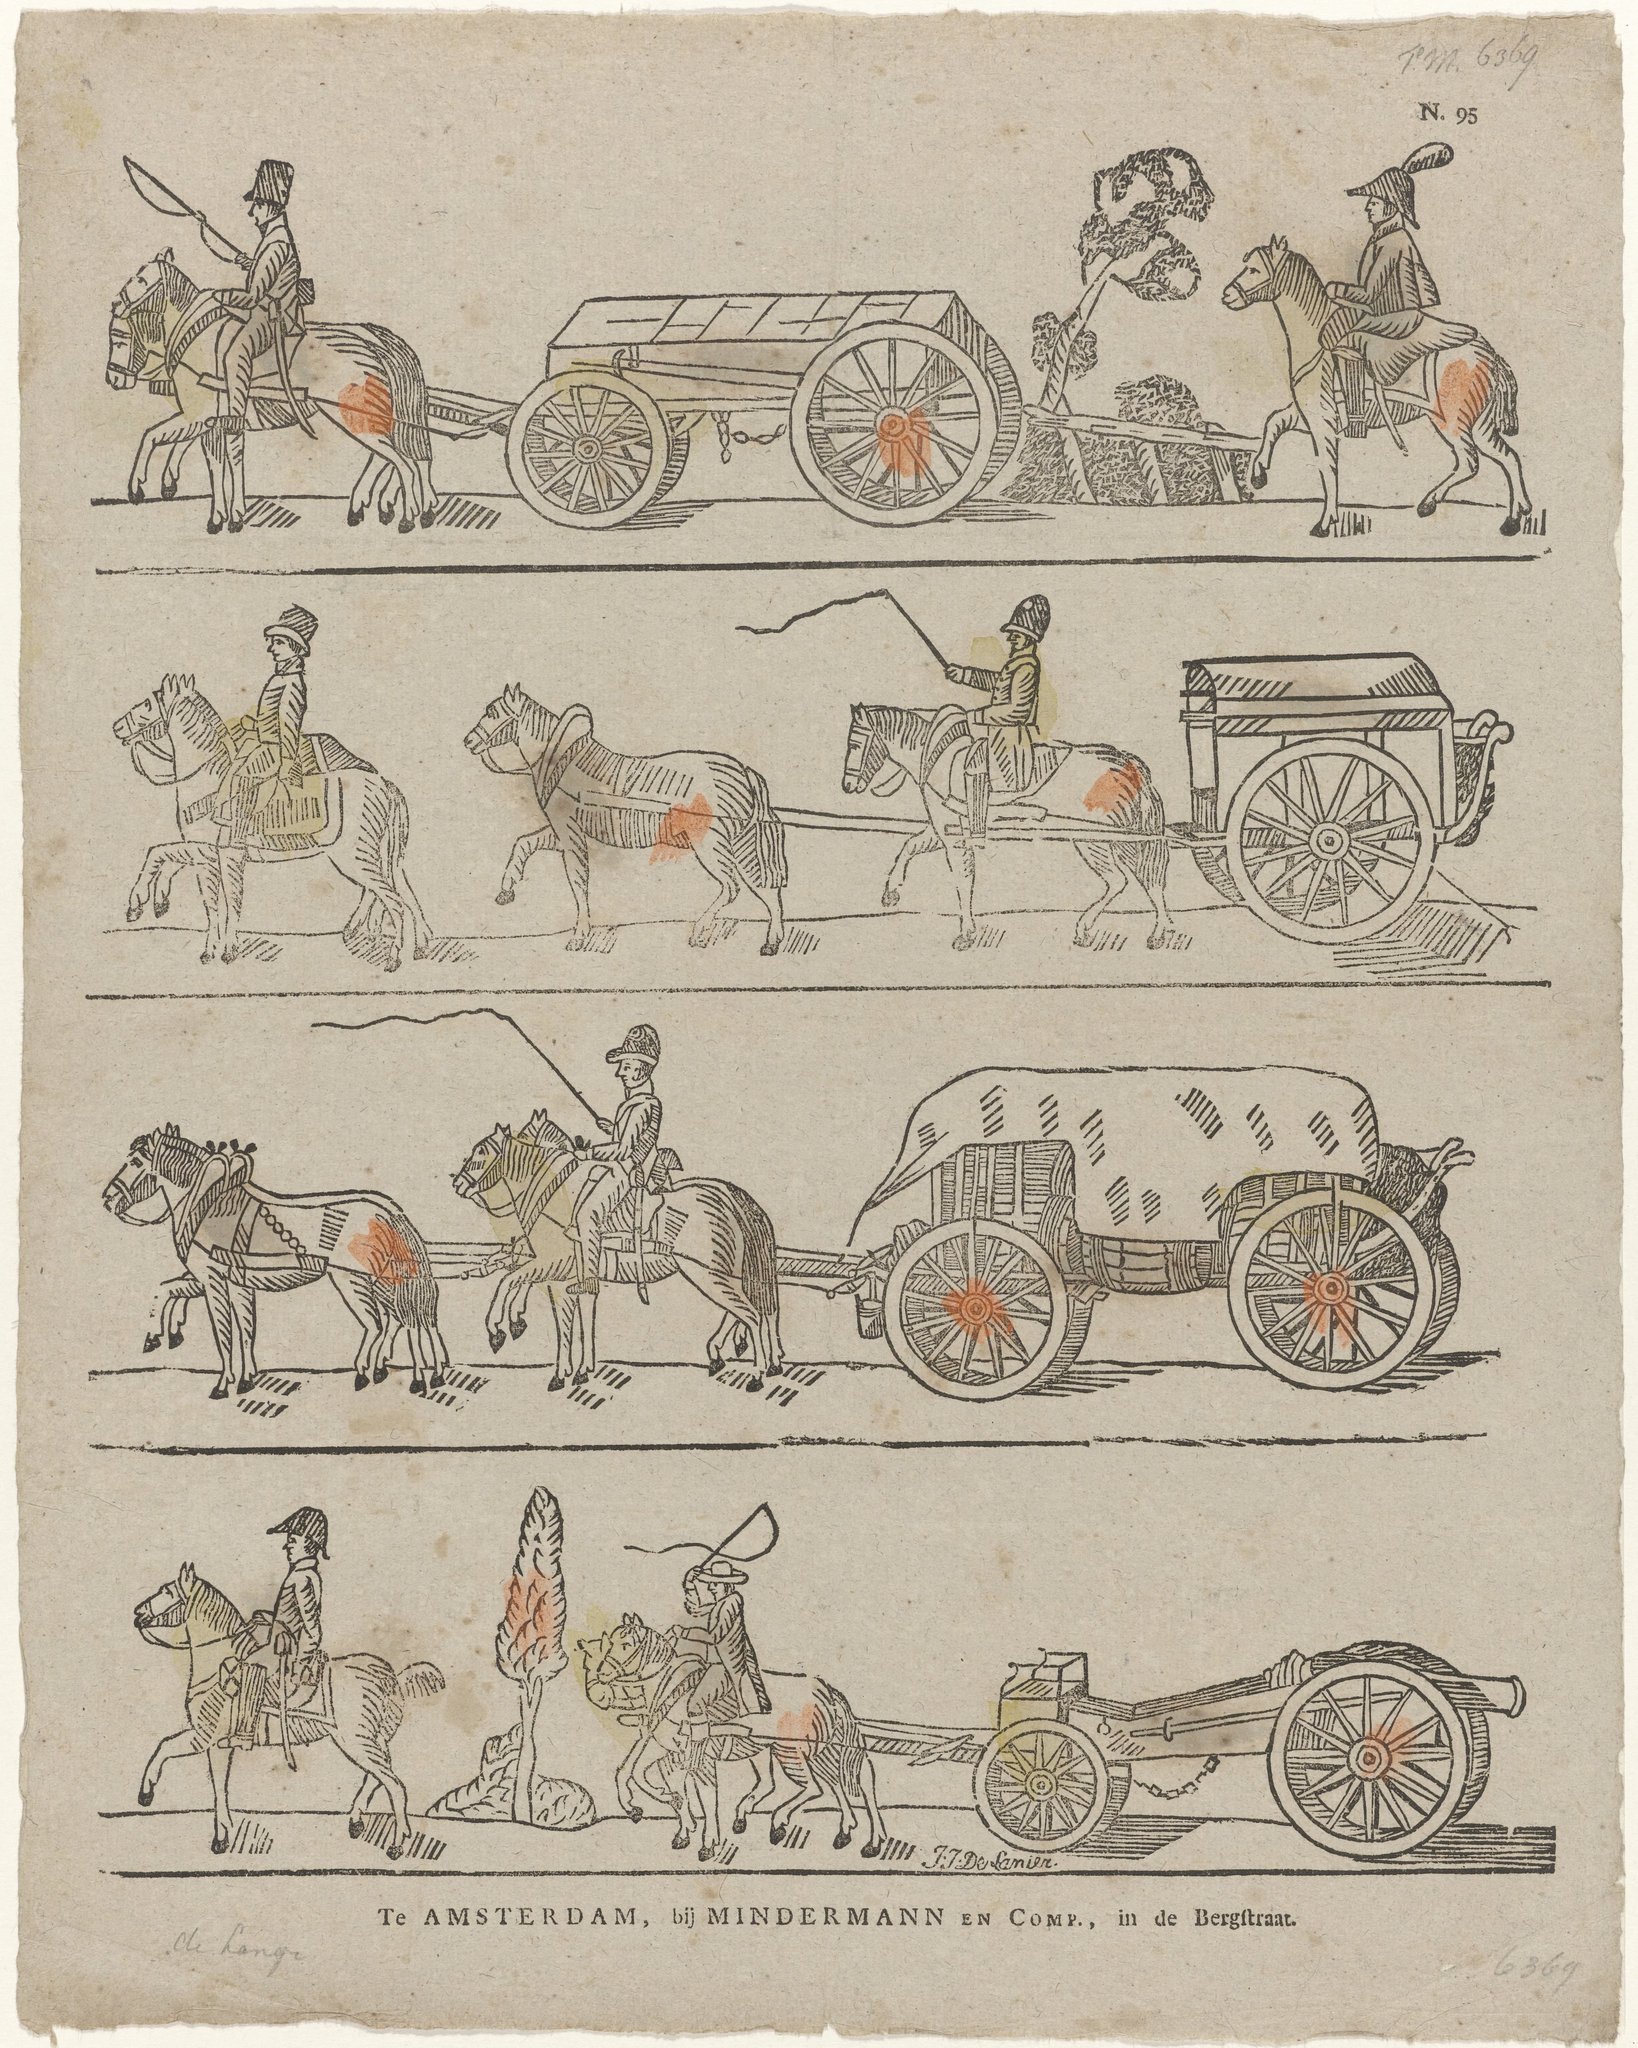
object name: popular print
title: Legertrein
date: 1815-1850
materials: paper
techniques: colour, letterpress printing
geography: netherlands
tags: transport, train (military) (+ land forces)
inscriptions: collector's mark: Lugt 2228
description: Blad met vier voorstellingen van de onderdelen van een legertrein. Zonder titel of teksten. Genummerd rechtsboven: N. 95. Ca. 1815-1850.